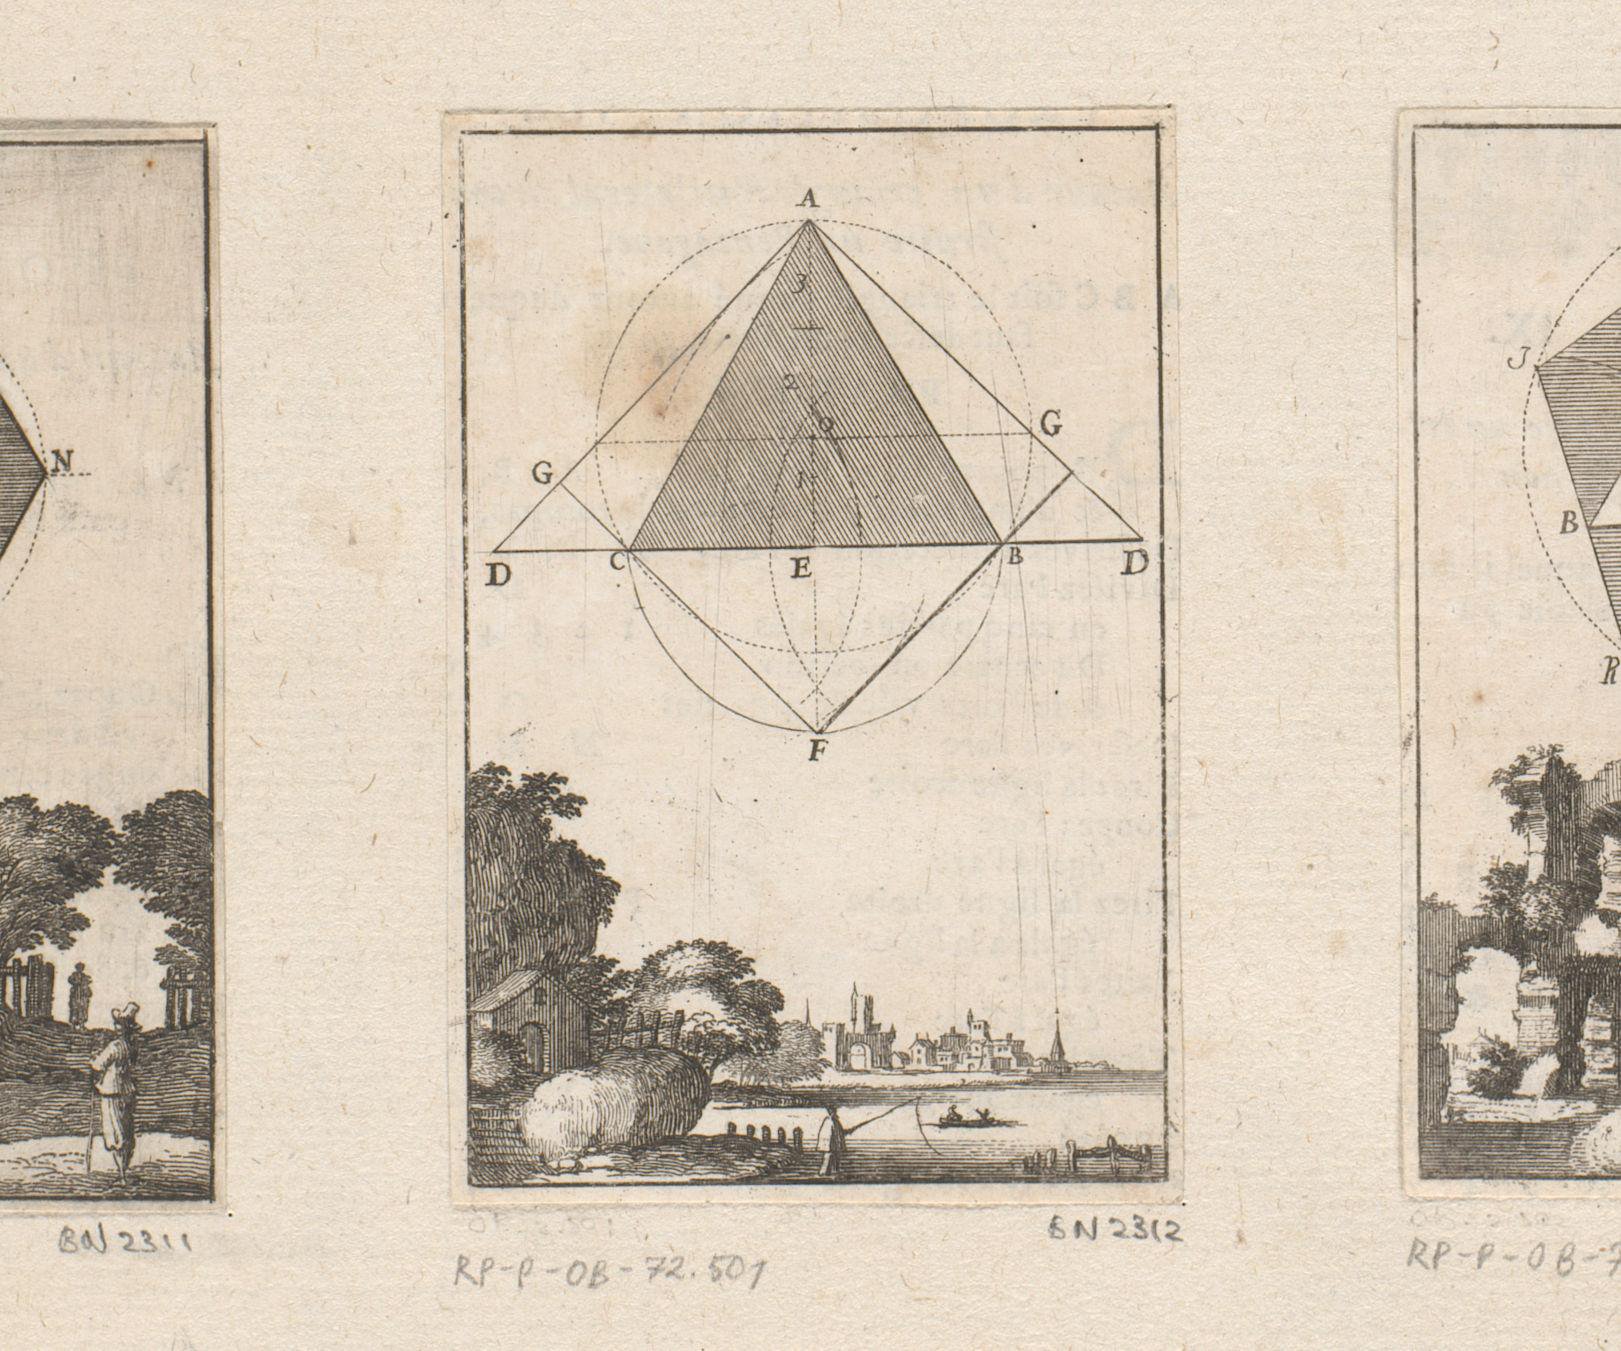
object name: print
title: Vierkant rond een gelijkbenige driehoek met onderaan een landschap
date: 1669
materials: paper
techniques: etching, letterpress printing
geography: france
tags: landscapes, planimetry, geometry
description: Prent uit: Pratique de la géometrie, sur le papier et sur le terrain. Avec un nouvel ordre et une méthode particulière. Parijs: Thomas Jolly, 1669.